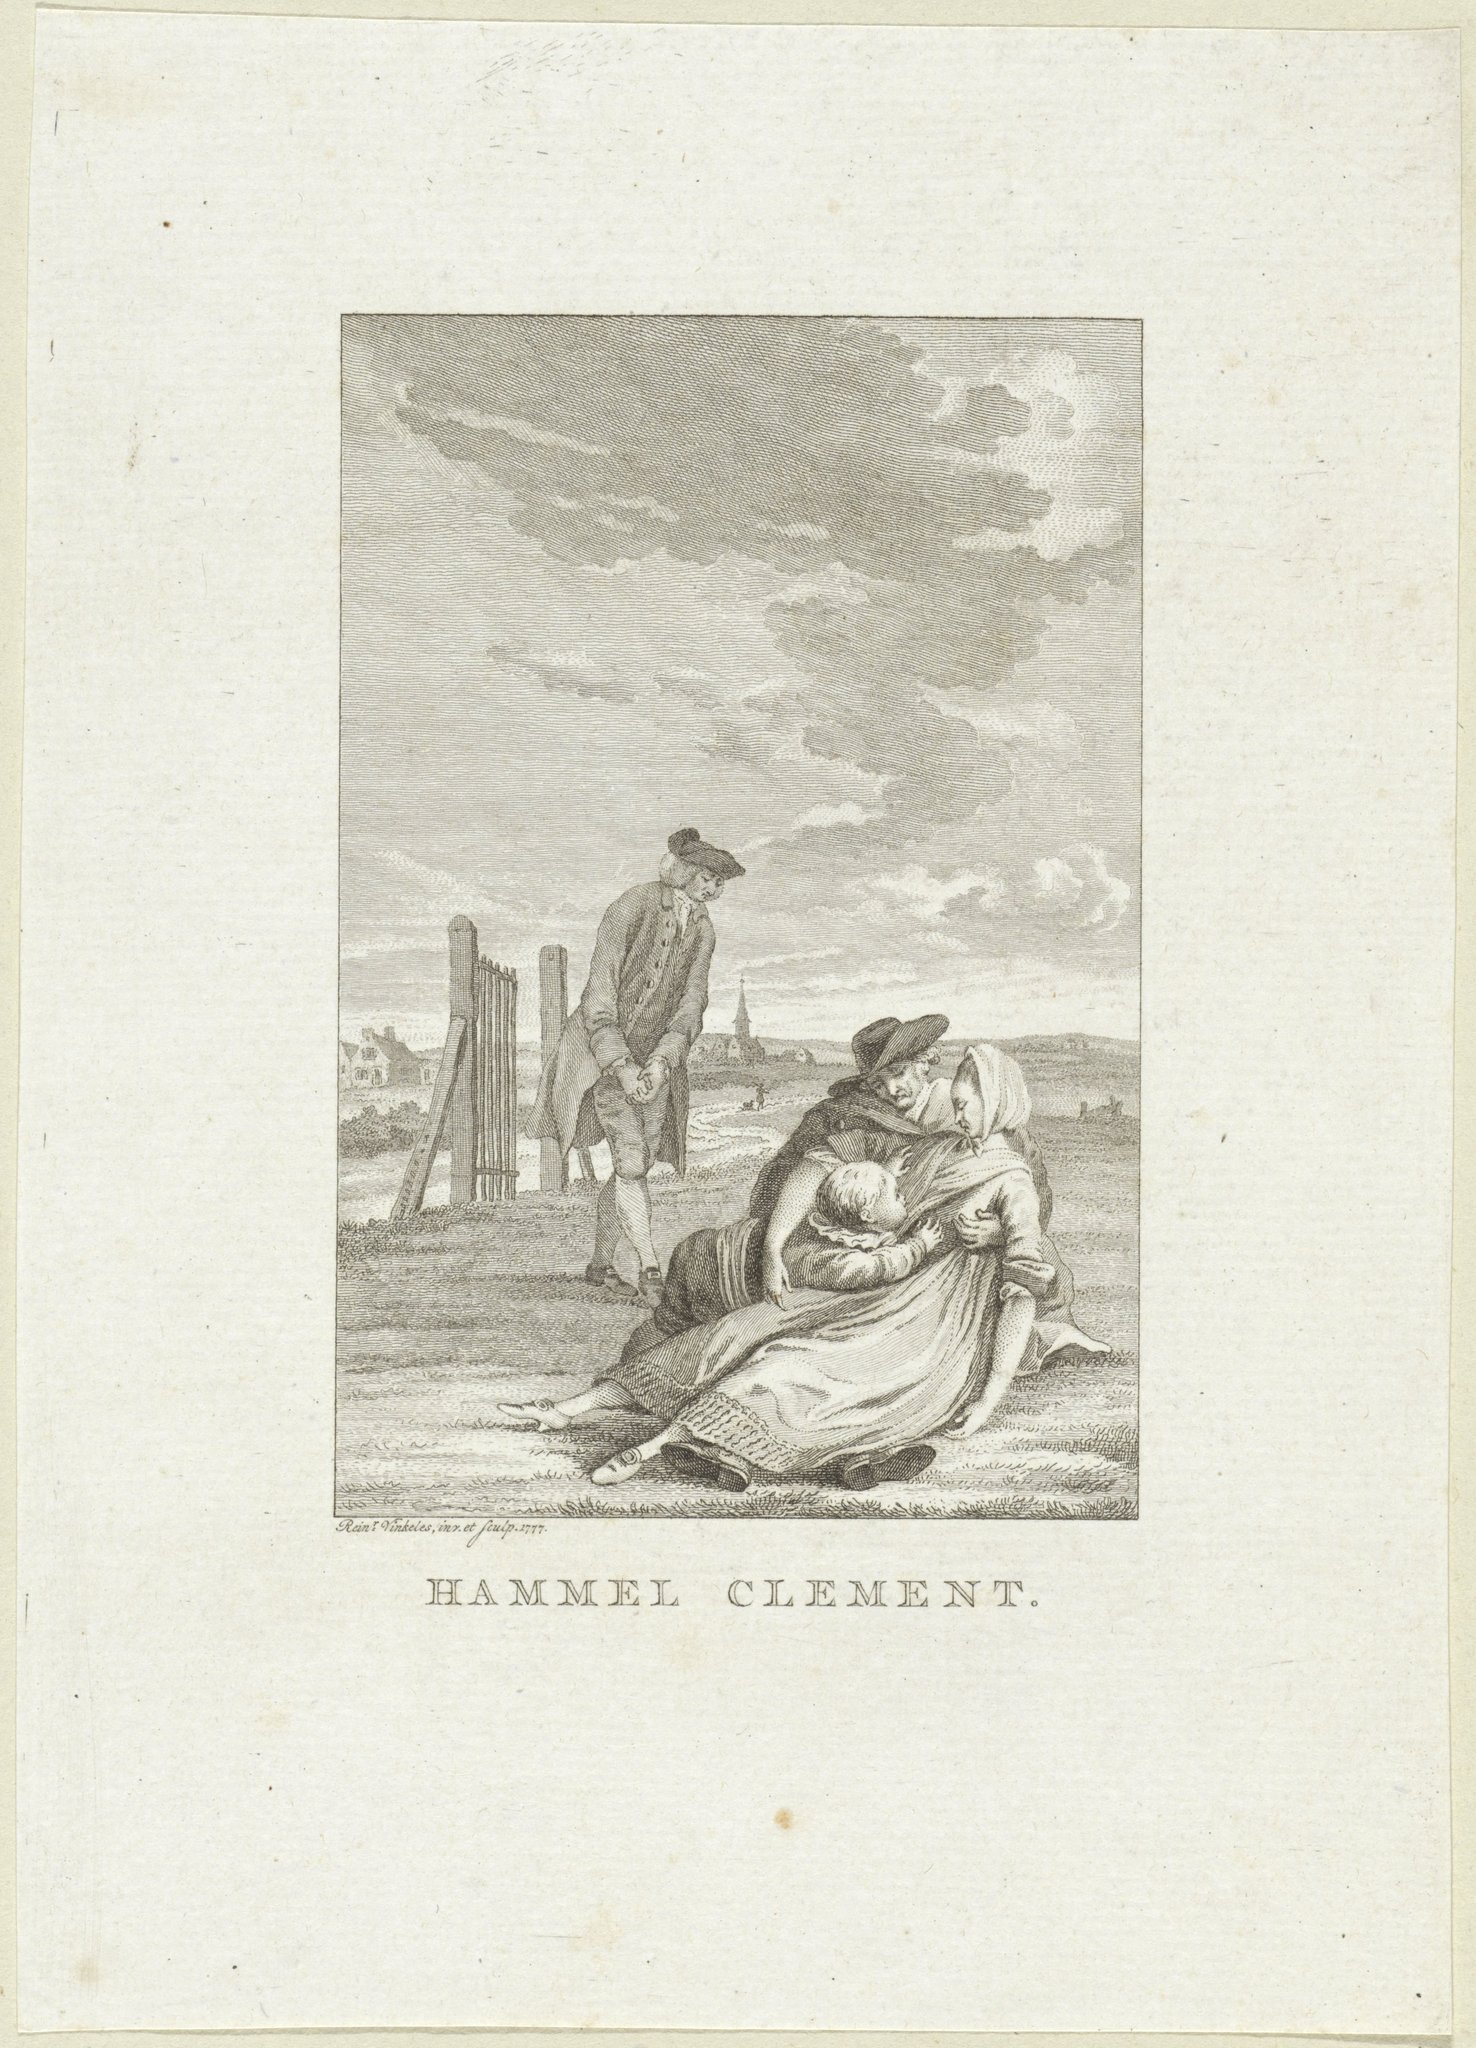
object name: print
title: Landschap met een vrouw, man en een kind in omhelzing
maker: reinier vinkeles (i)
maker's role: draughtsman, print maker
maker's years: 1741-1816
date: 1777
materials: paper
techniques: engraving, etching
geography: amsterdam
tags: landscapes, embracing each other, kissing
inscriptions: collector's mark: Lugt 240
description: Deze prent is ook gebruikt als illustratie bij het verhaal 'Hammel Clement' voor: Brooke, H. Zedelijke verhaalen, deel 2. Amsterdam: A. Mens Jansz. en A.E. Munnikhuisen, 1777.